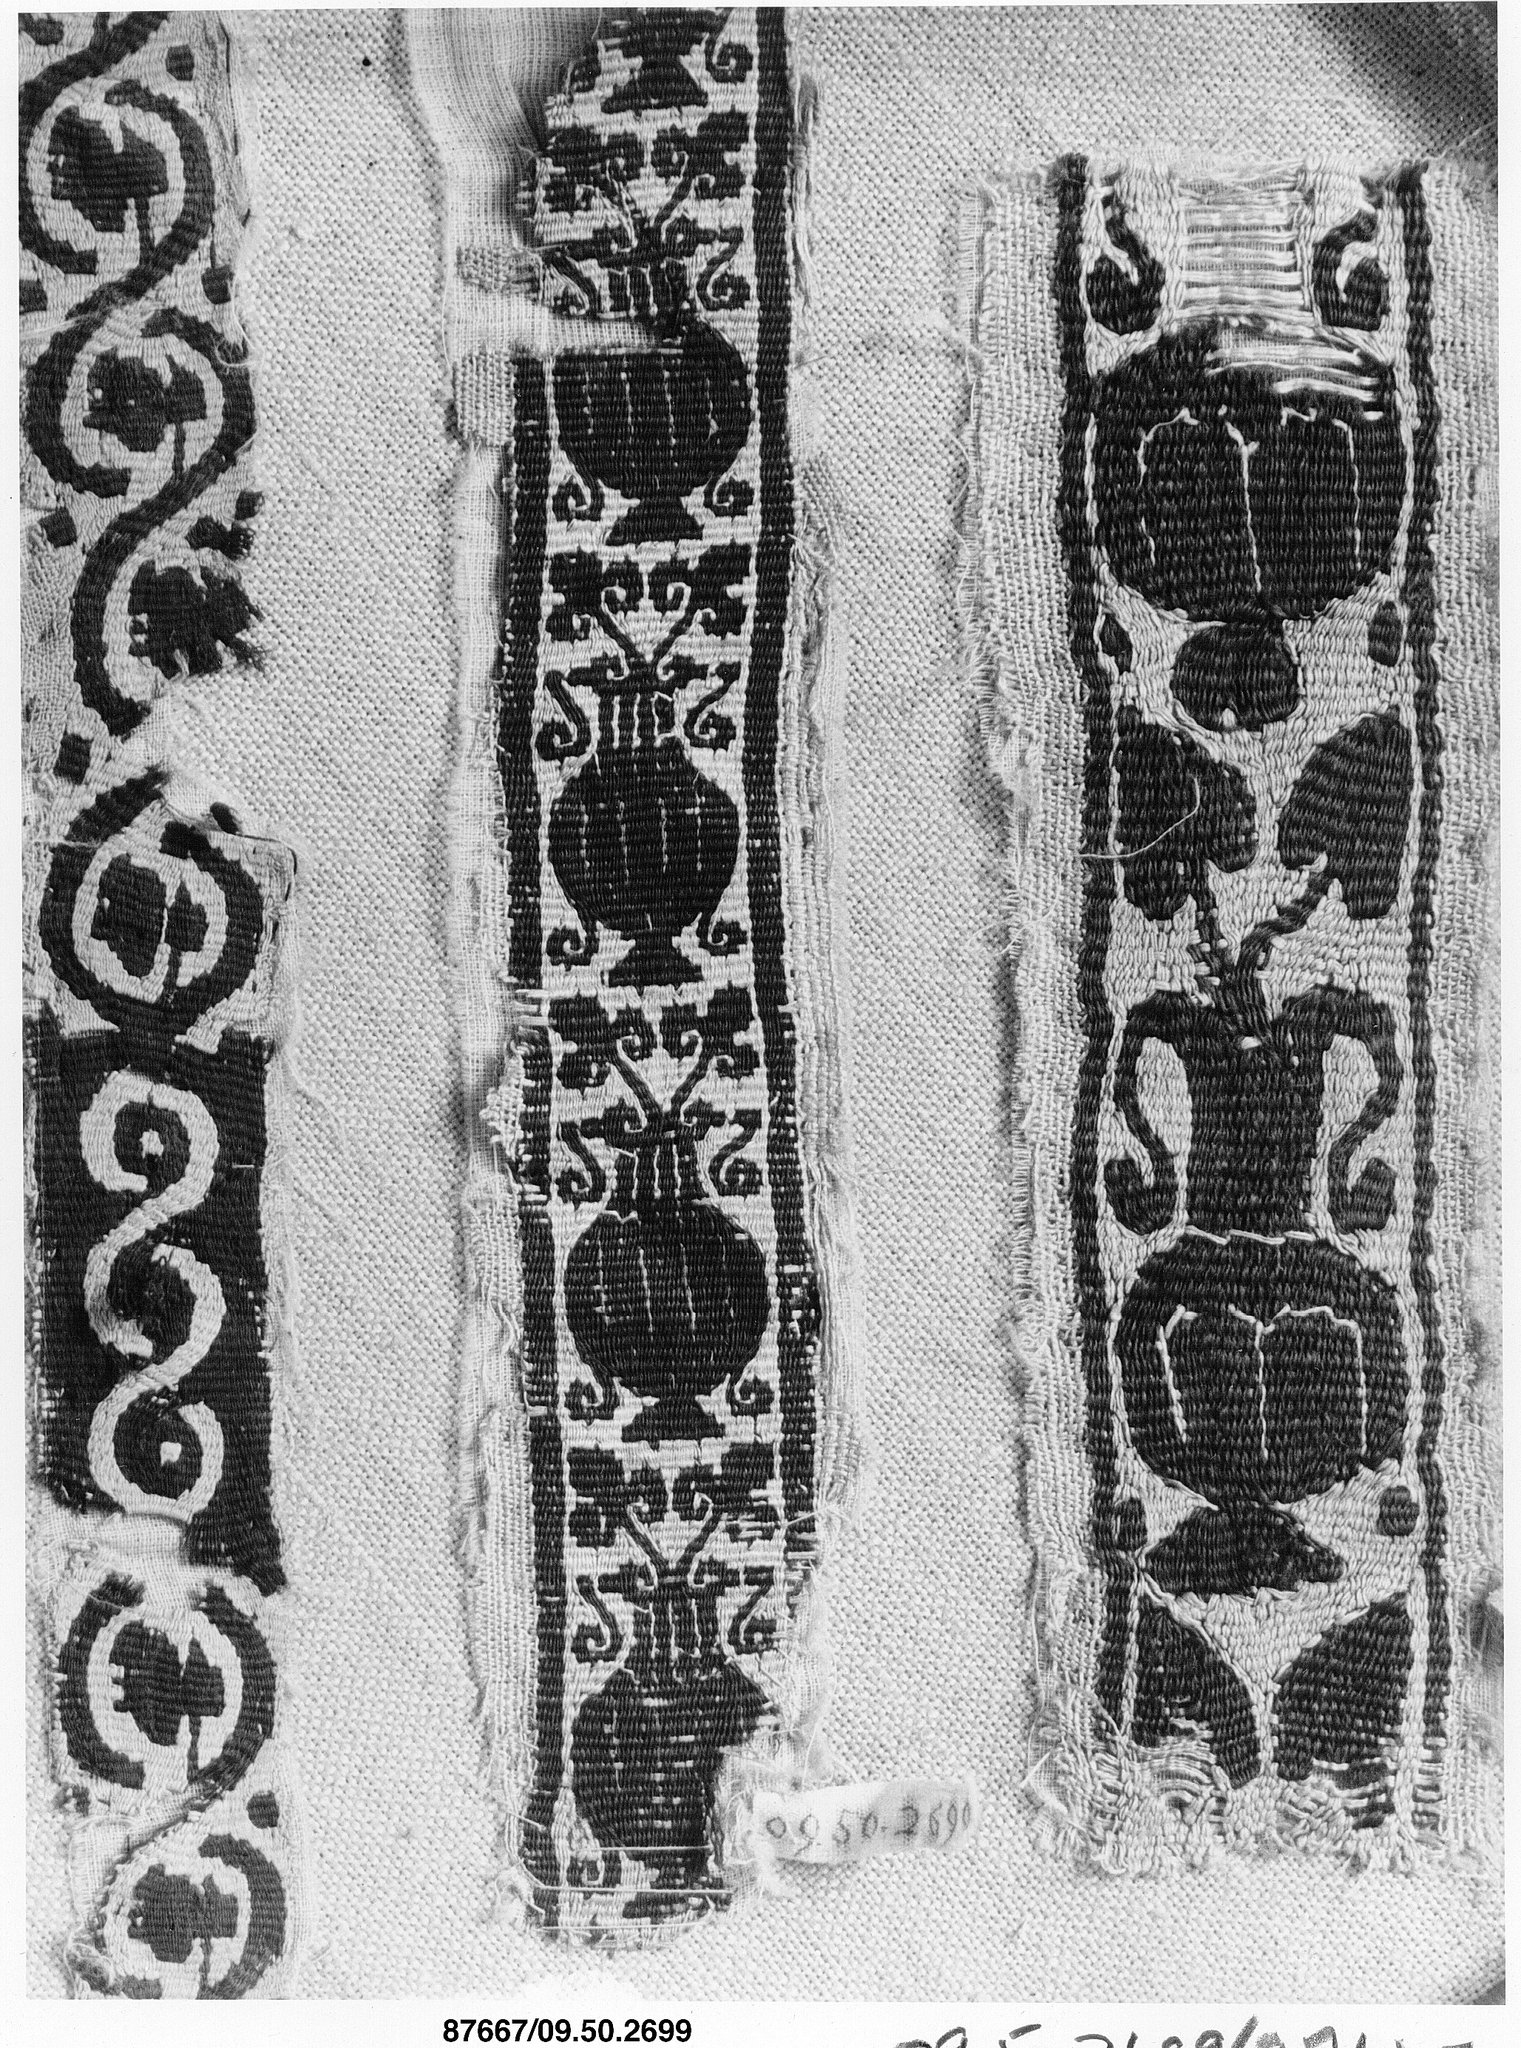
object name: band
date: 301-400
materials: linen, wool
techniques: weave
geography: egypt